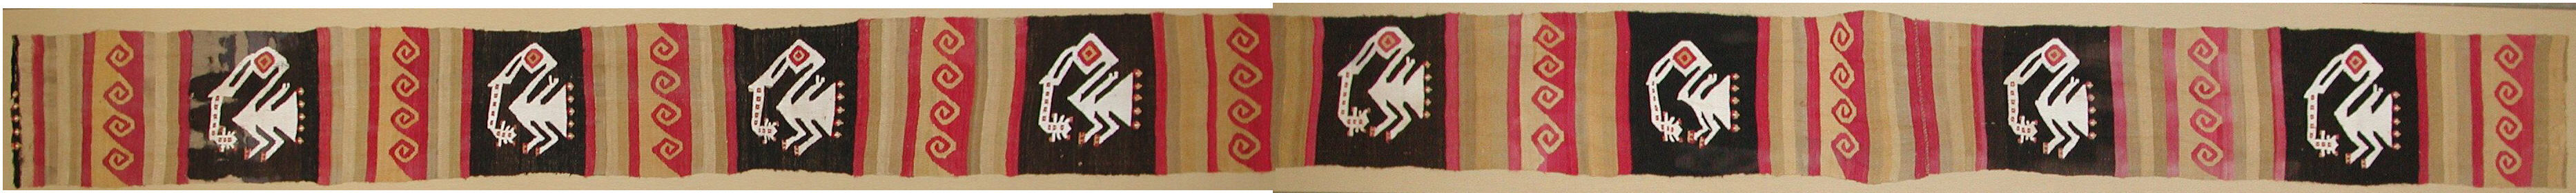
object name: band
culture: chancay or chimú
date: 1001-1466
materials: animal fiber, cotton, fiber